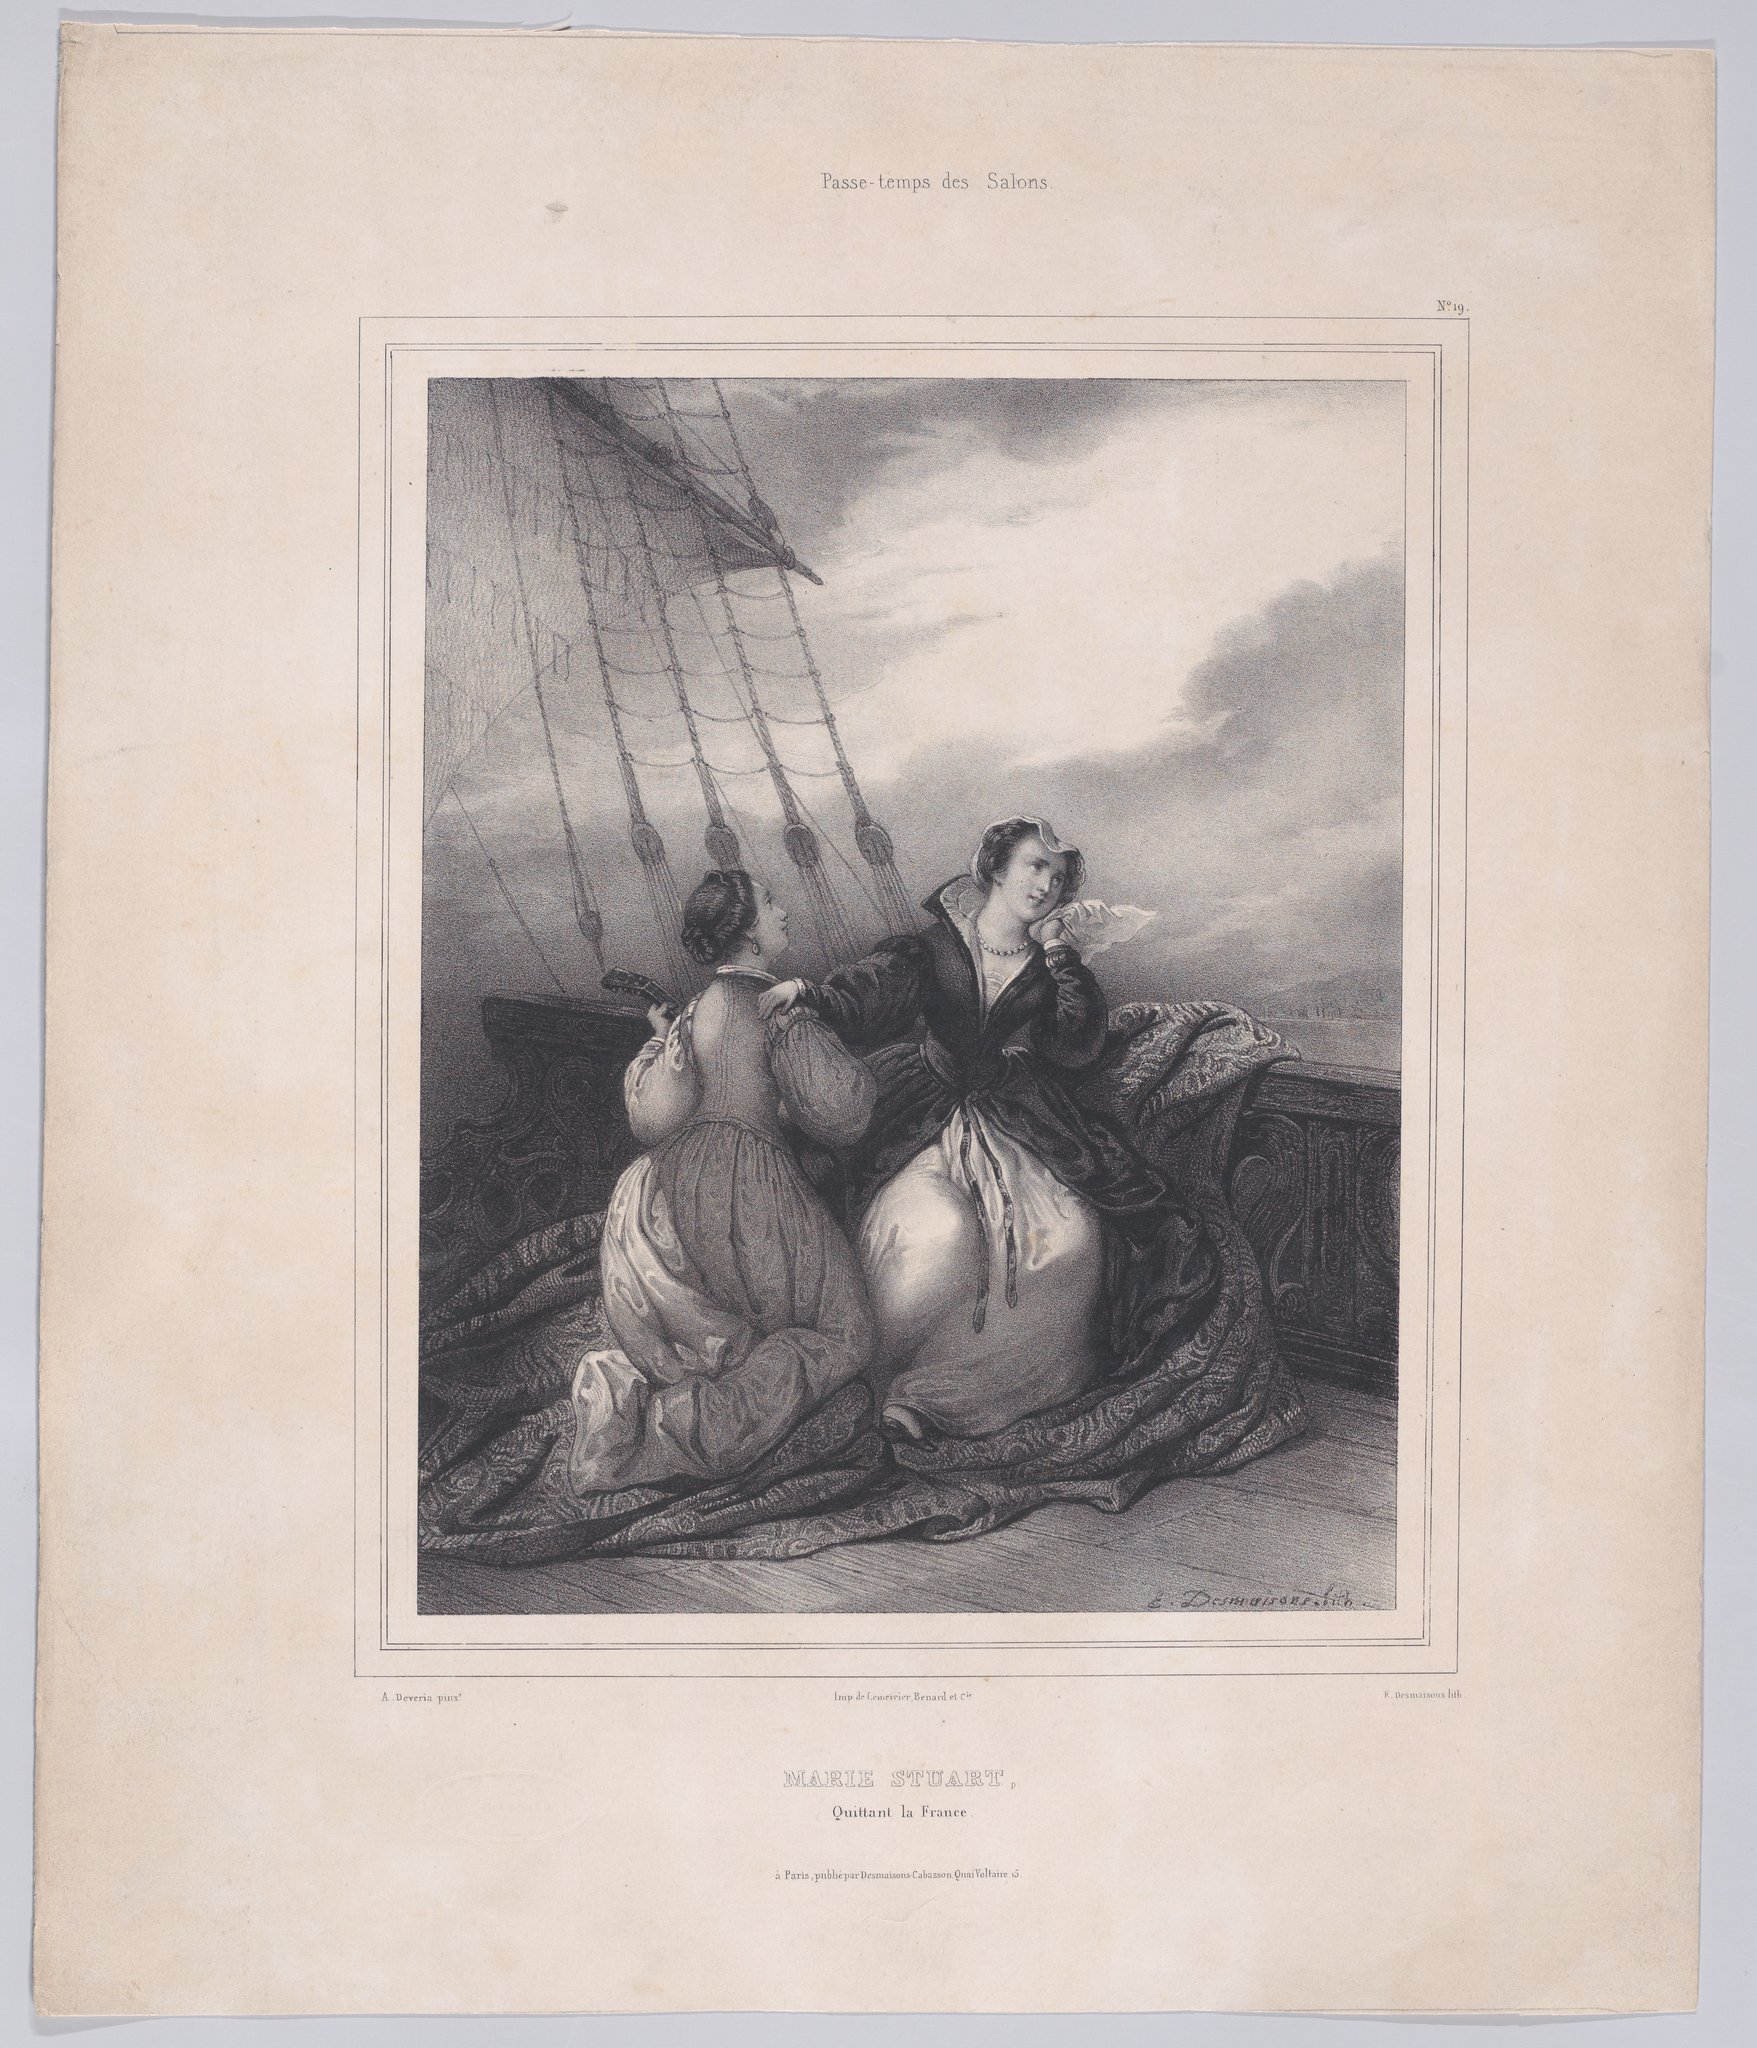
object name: print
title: Mary, Queen of Scots embarking at Calais to return to Scotland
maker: emile desmaisons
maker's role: artist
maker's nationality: french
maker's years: 1800-1880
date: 1880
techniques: lithograph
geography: france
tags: queens,women,mary queen of scots